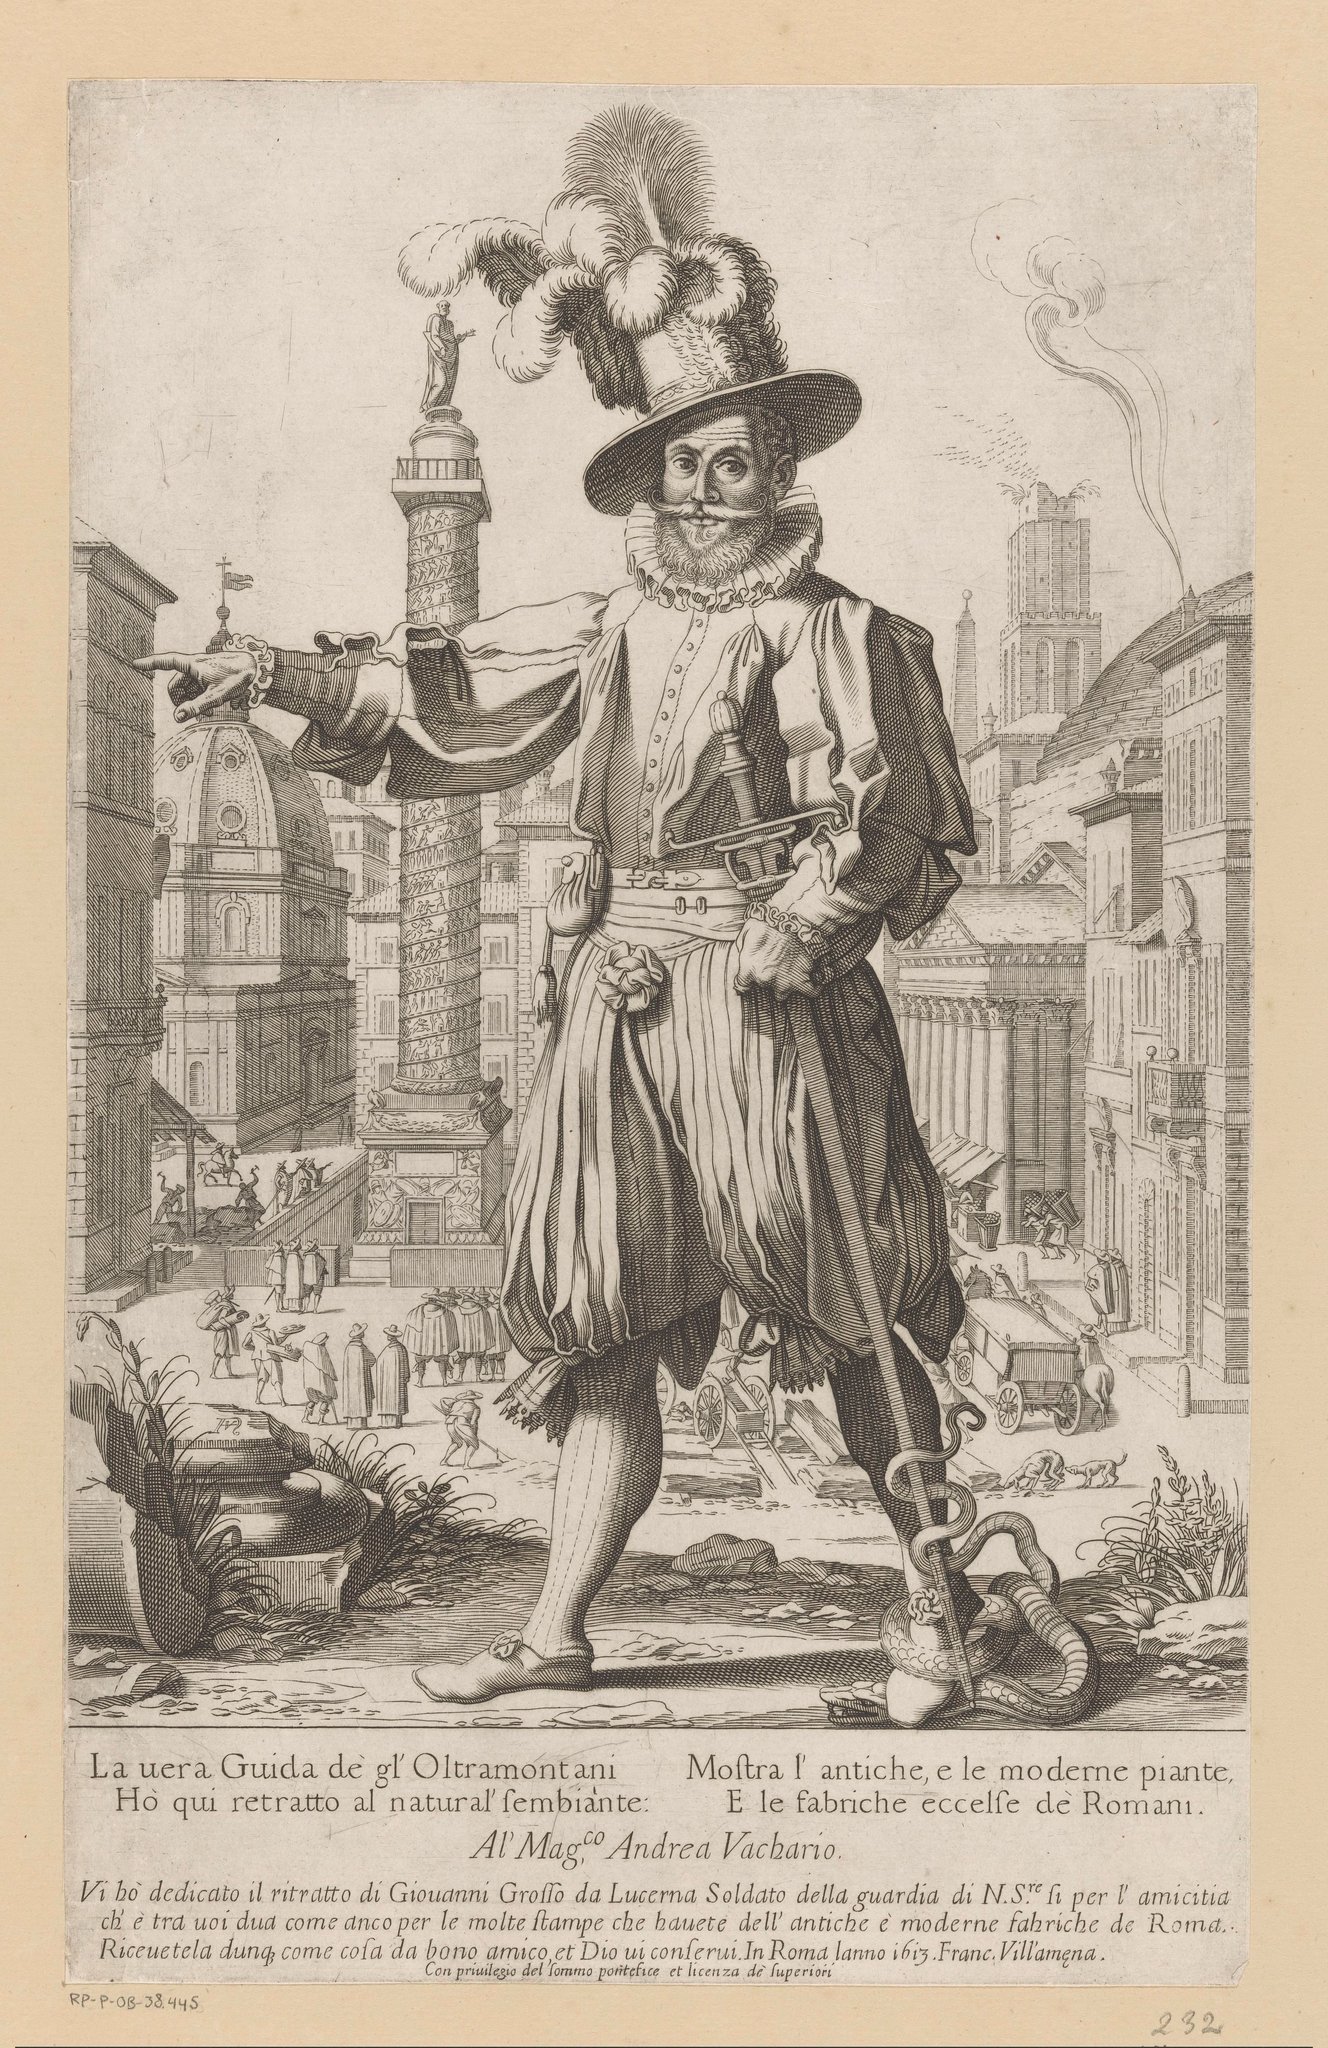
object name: print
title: Portret van Giovanni Grosso, lid van de Zwitserse garde en gids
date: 1613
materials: paper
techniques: engraving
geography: rome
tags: city-view in general; 'veduta', historical persons, rome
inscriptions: collector's mark: Lugt 240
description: Portret ten voeten uit van Giovanni Grosso, staand op het Quirinaal te Rome. Met zijn linkervoet vertrapt hij een slang. Italiaanse tekst in twee kolommen en opdracht in ondermarge.